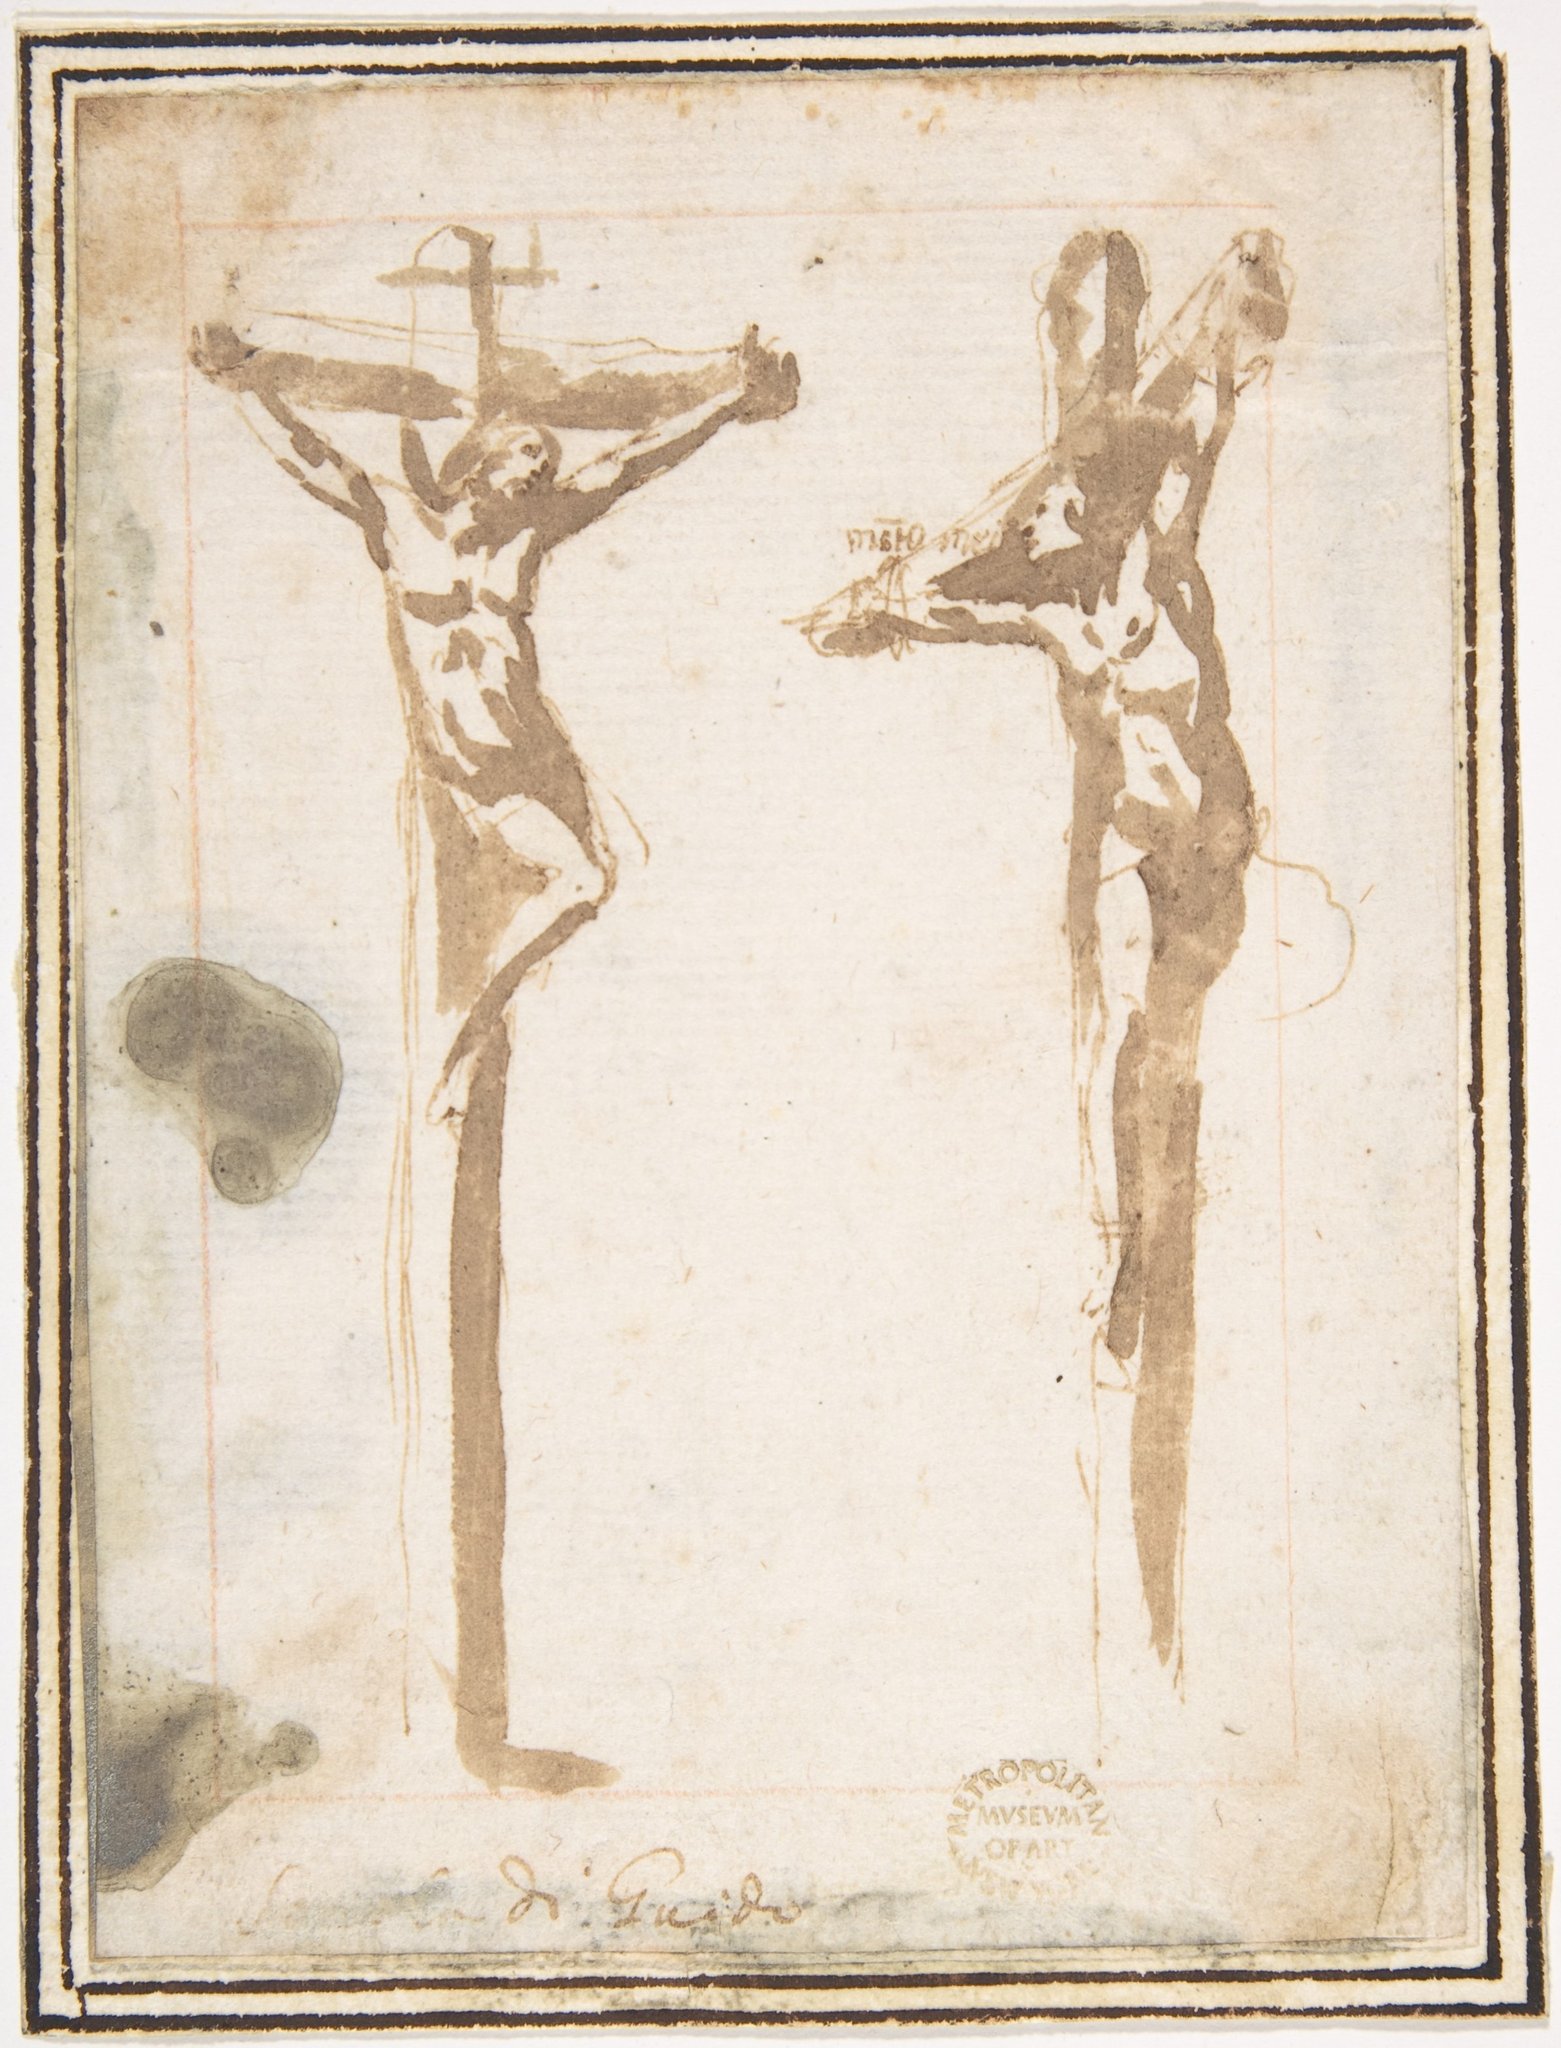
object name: drawing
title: Christ Crucified with the Good Thief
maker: francesco allegrini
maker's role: artist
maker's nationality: italian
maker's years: 1615-1679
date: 1624-1663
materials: chalk, ink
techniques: brush, pen, wash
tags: christ,crucifixion